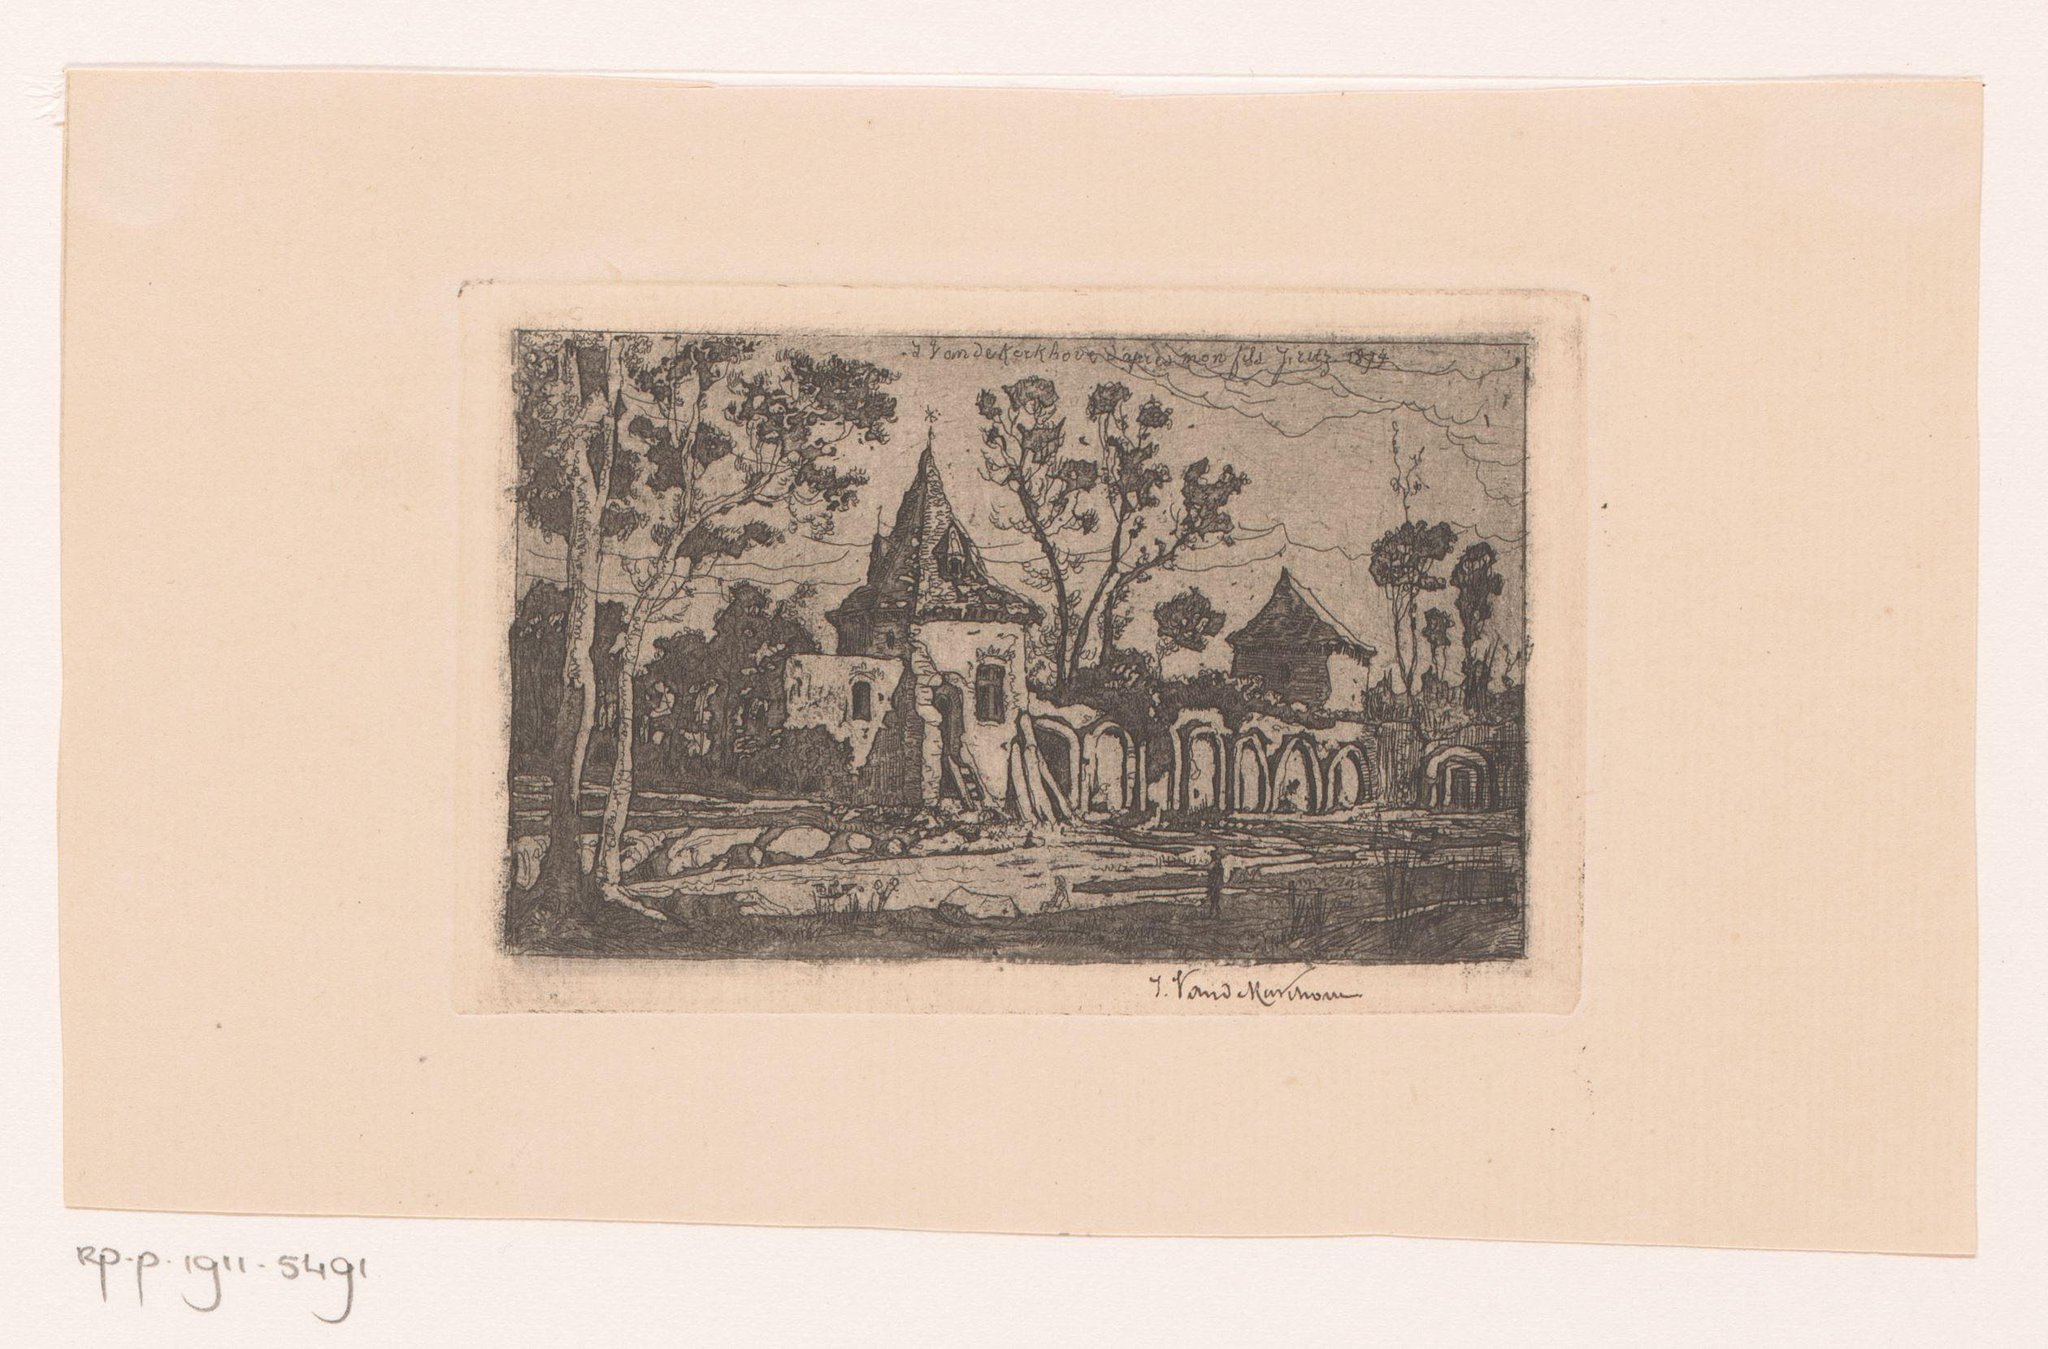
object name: print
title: Ruïne van een abdij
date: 1874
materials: paper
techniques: etching, intaglio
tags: ruin of church, monastery, etc.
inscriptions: collector's mark: Lugt 2228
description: De etsen naar de schilderijen van Frédéric Van de Kerkhove werden na zijn dood door zijn vader en zuster gemaakt en uitgegeven in twee reeksen. De eerste werd in 1877 uitgegeven door het Journal des Beaux-Arts et de la Littérature: Cahier de 25 Eaux-fortes d'après Frédéric van de Kerkhove, gravées par son père et sa sœur. De tweede reeks van 126 etsen, ook in 1877, werd in Parijs uitgegeven bij A. Lévy onder de titel Cent eaux-fortes gravées par J. Van de Kerkhove d'après les tableaux de Frédéric Van de Kerkhove, mort en 1873 à l'âge de 10 ans et 11 mois.